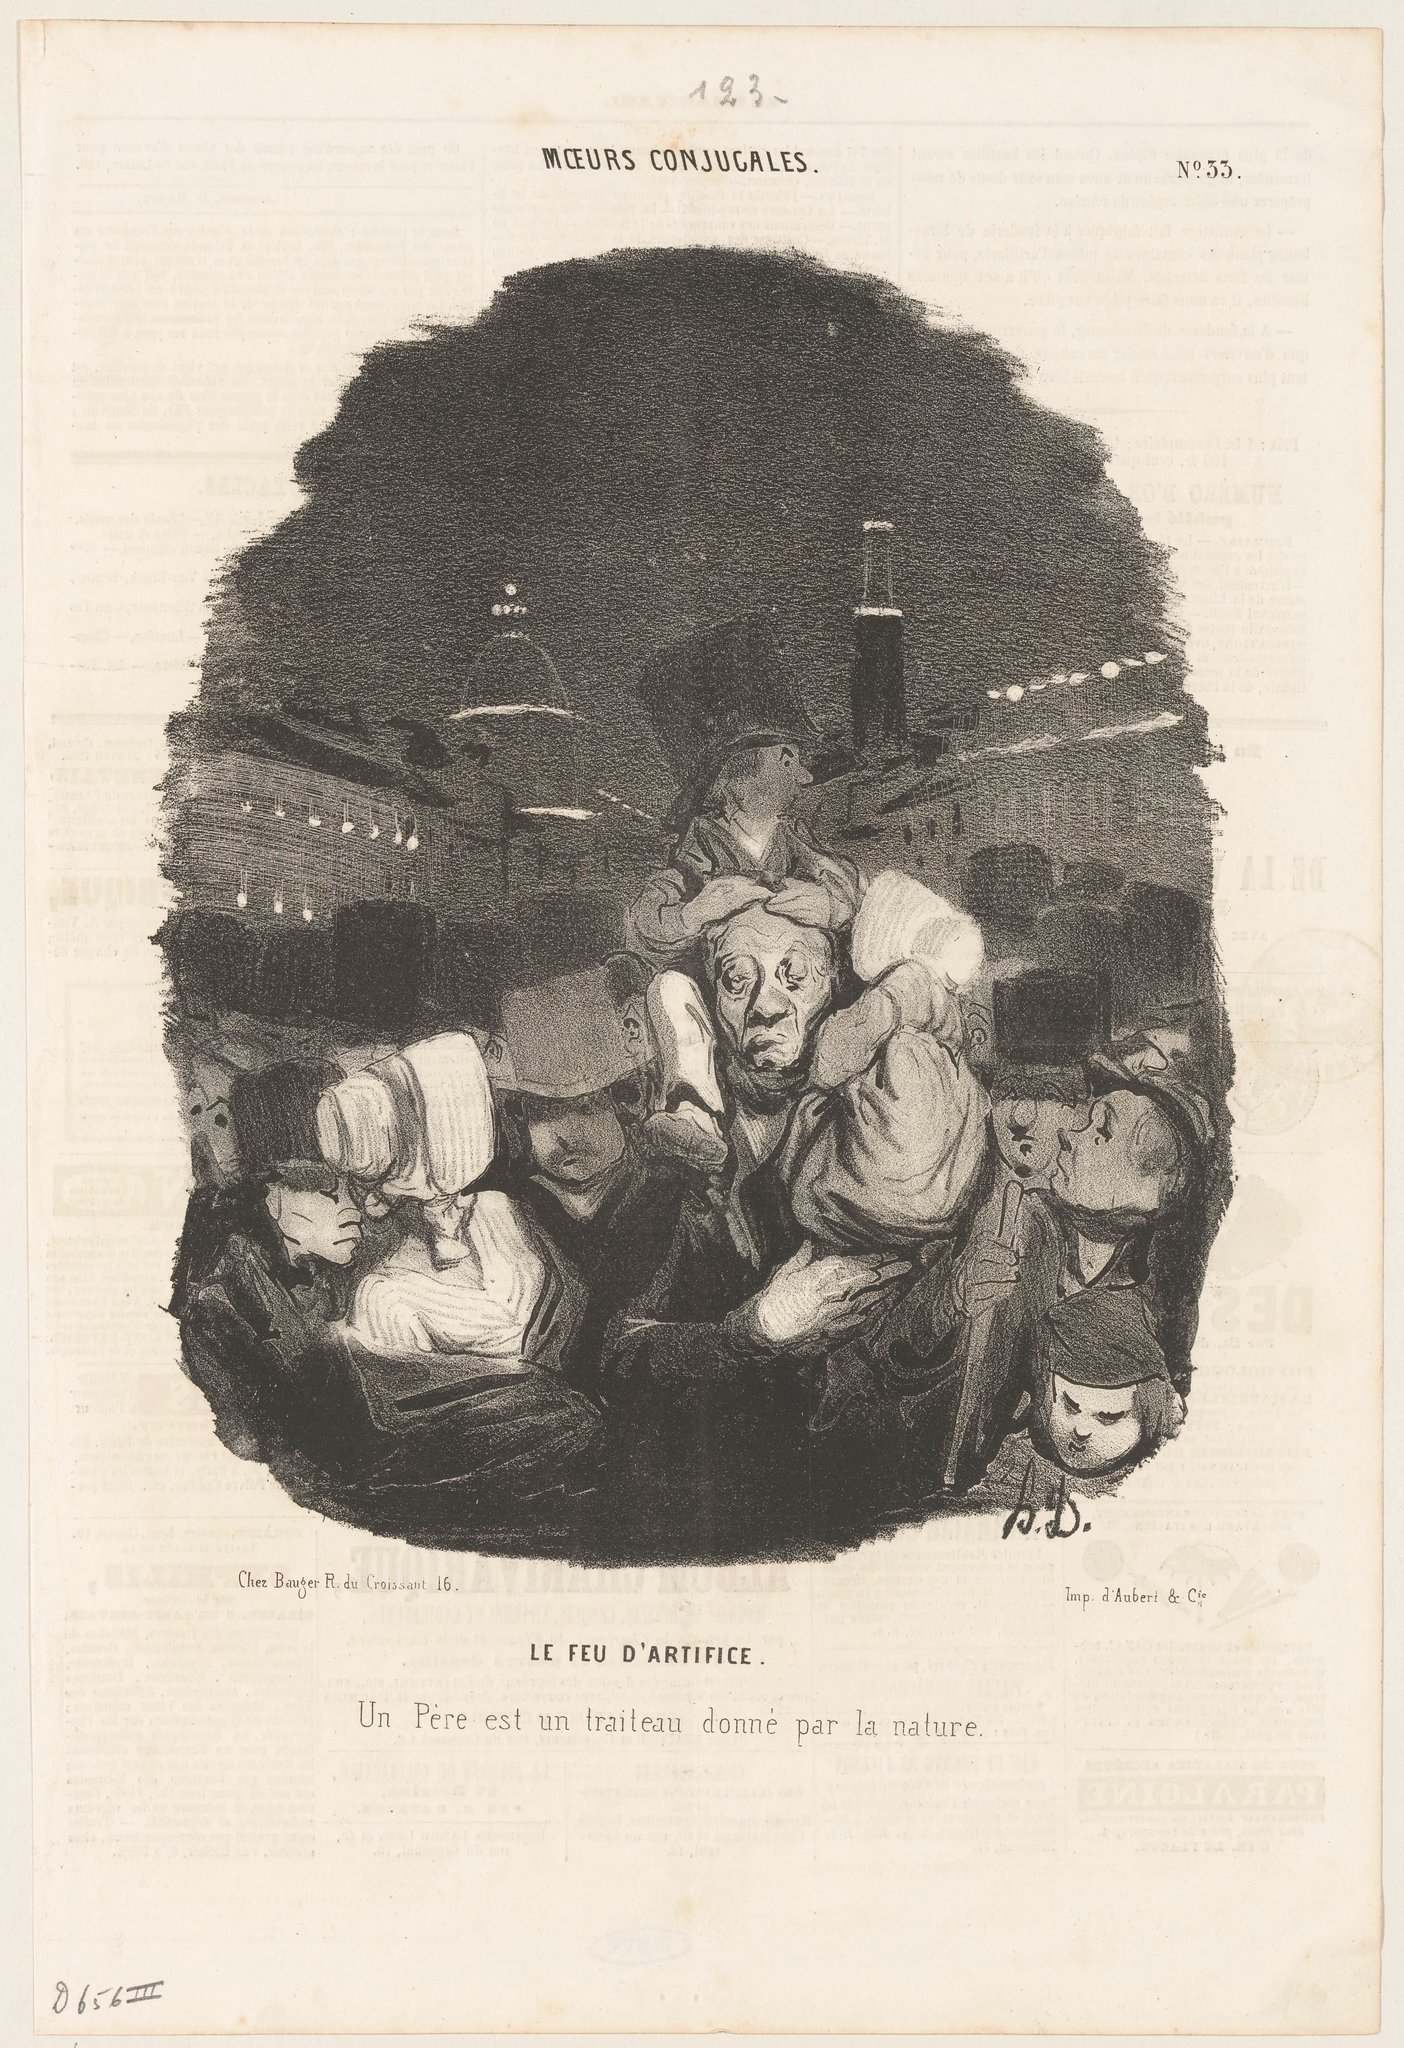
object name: cartoon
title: Moeurs conjugales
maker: honoré daumier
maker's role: draughtsman, painter, print maker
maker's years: 1808-1879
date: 1841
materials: paper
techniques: letterpress printing, lithograph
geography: paris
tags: father with son(s) and daughter(s) (father-love), caricatures (human types), father and child(ren), man and child(ren) (family group)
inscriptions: collector's mark: Lugt 2228a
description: Prent uit: Le Charivari, 30/31 juli 1841. Prent voor het eerst gebruikt in: La Caricature (2e serie), nr. 32, 9 augustus 1840.